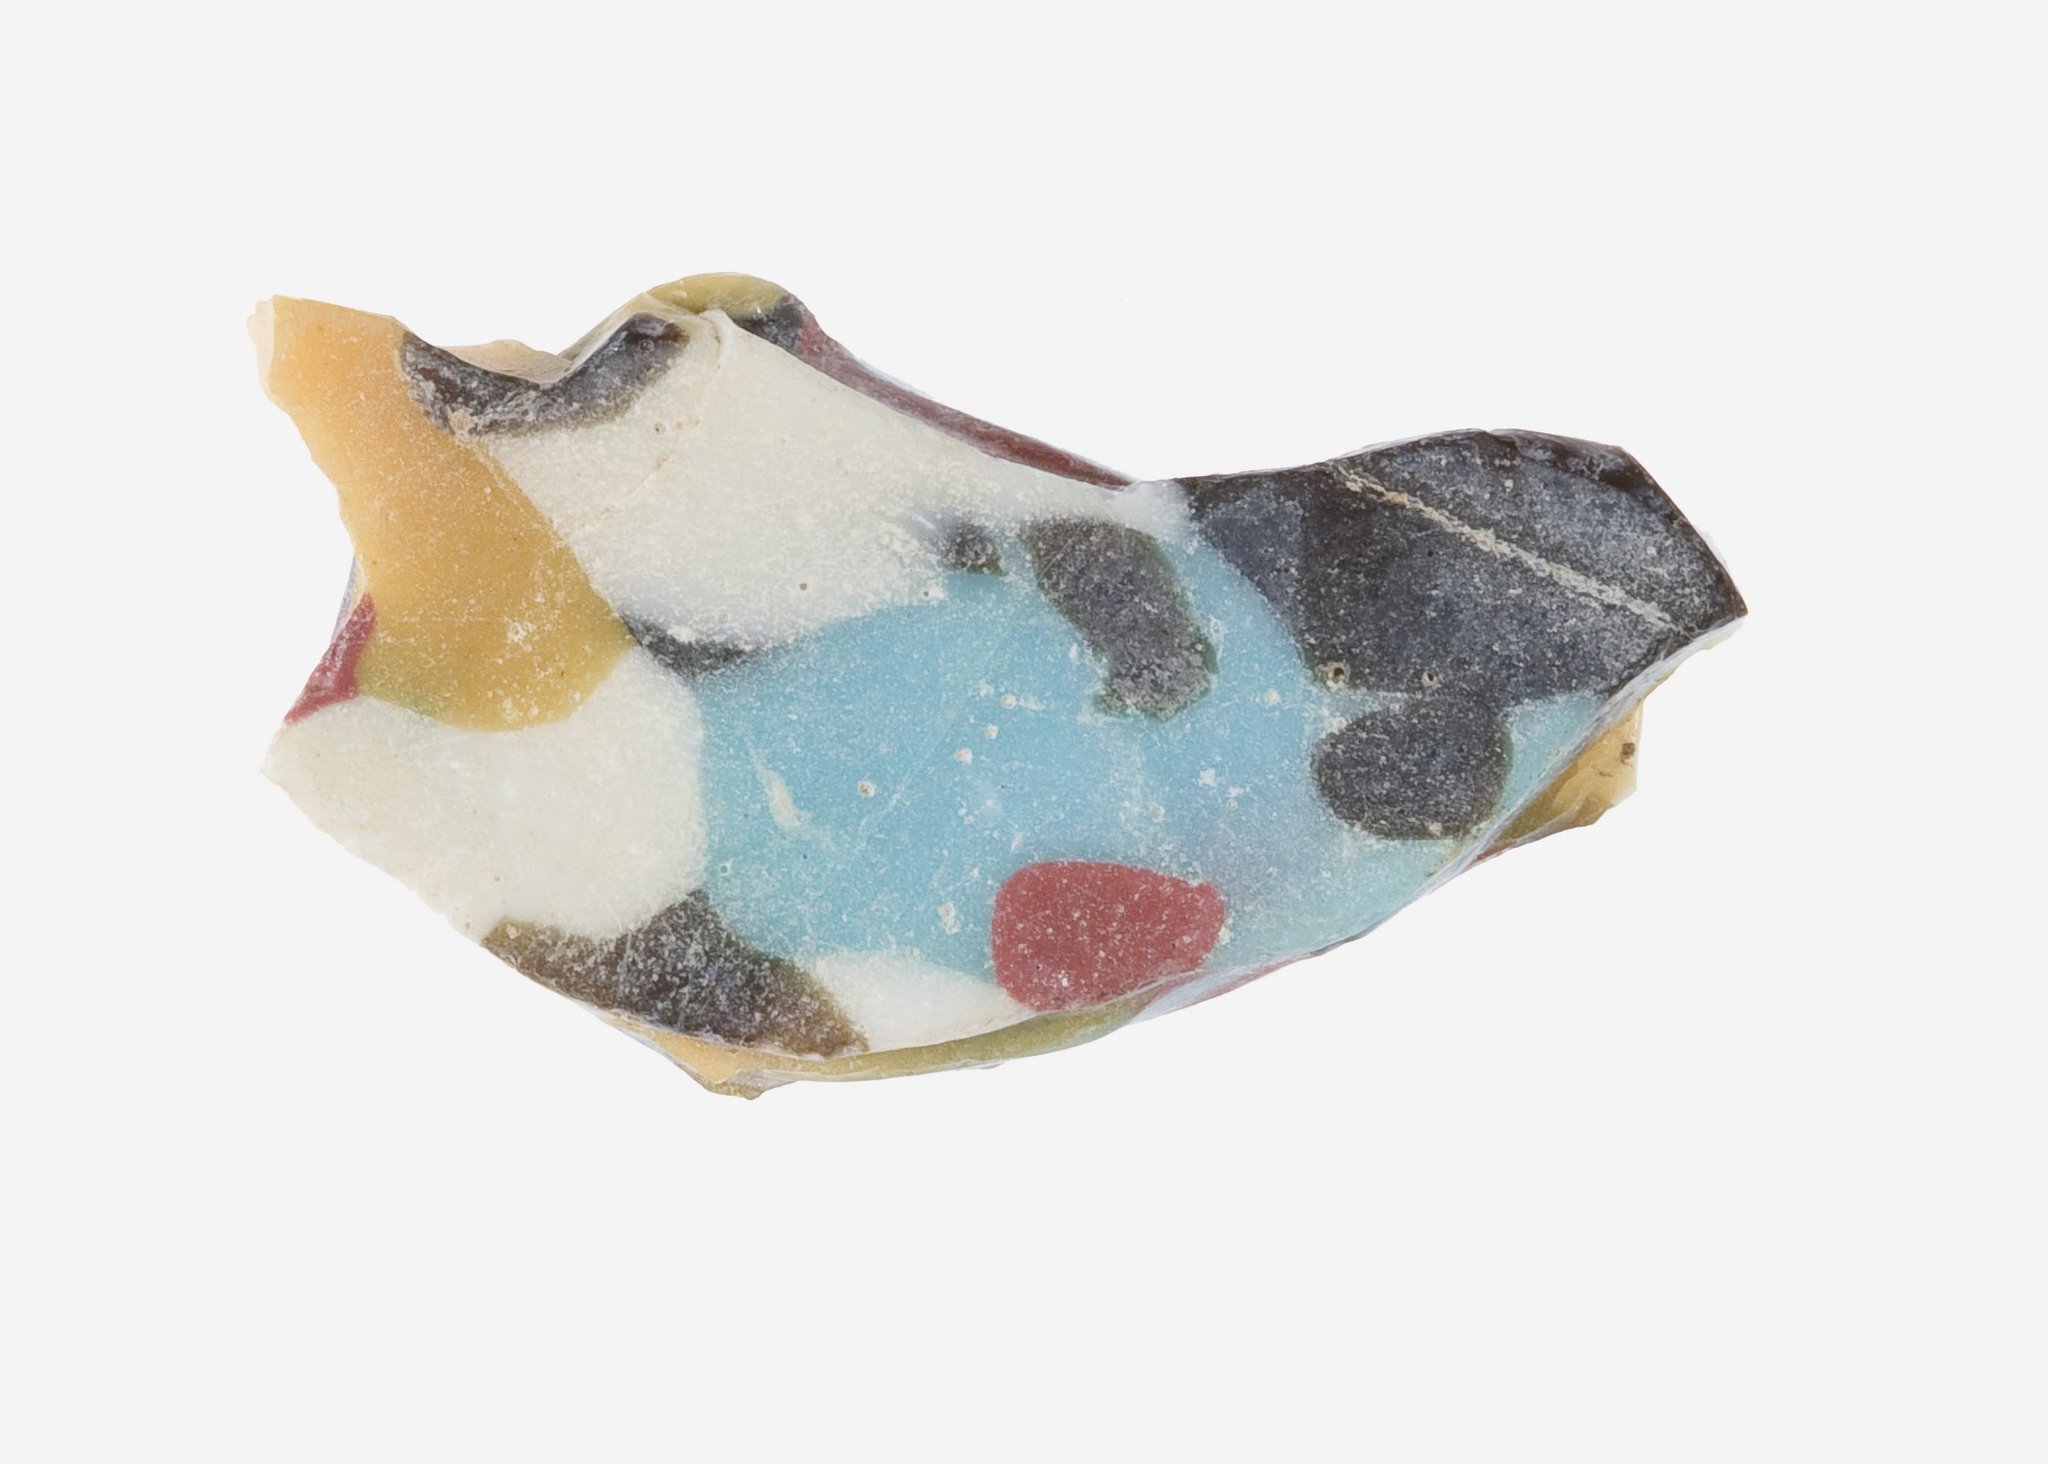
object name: vessel fragment, mosaic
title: Fragment of a Dish of Polychrome Mosaic Glass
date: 1390-1352 BCE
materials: glass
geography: egypt